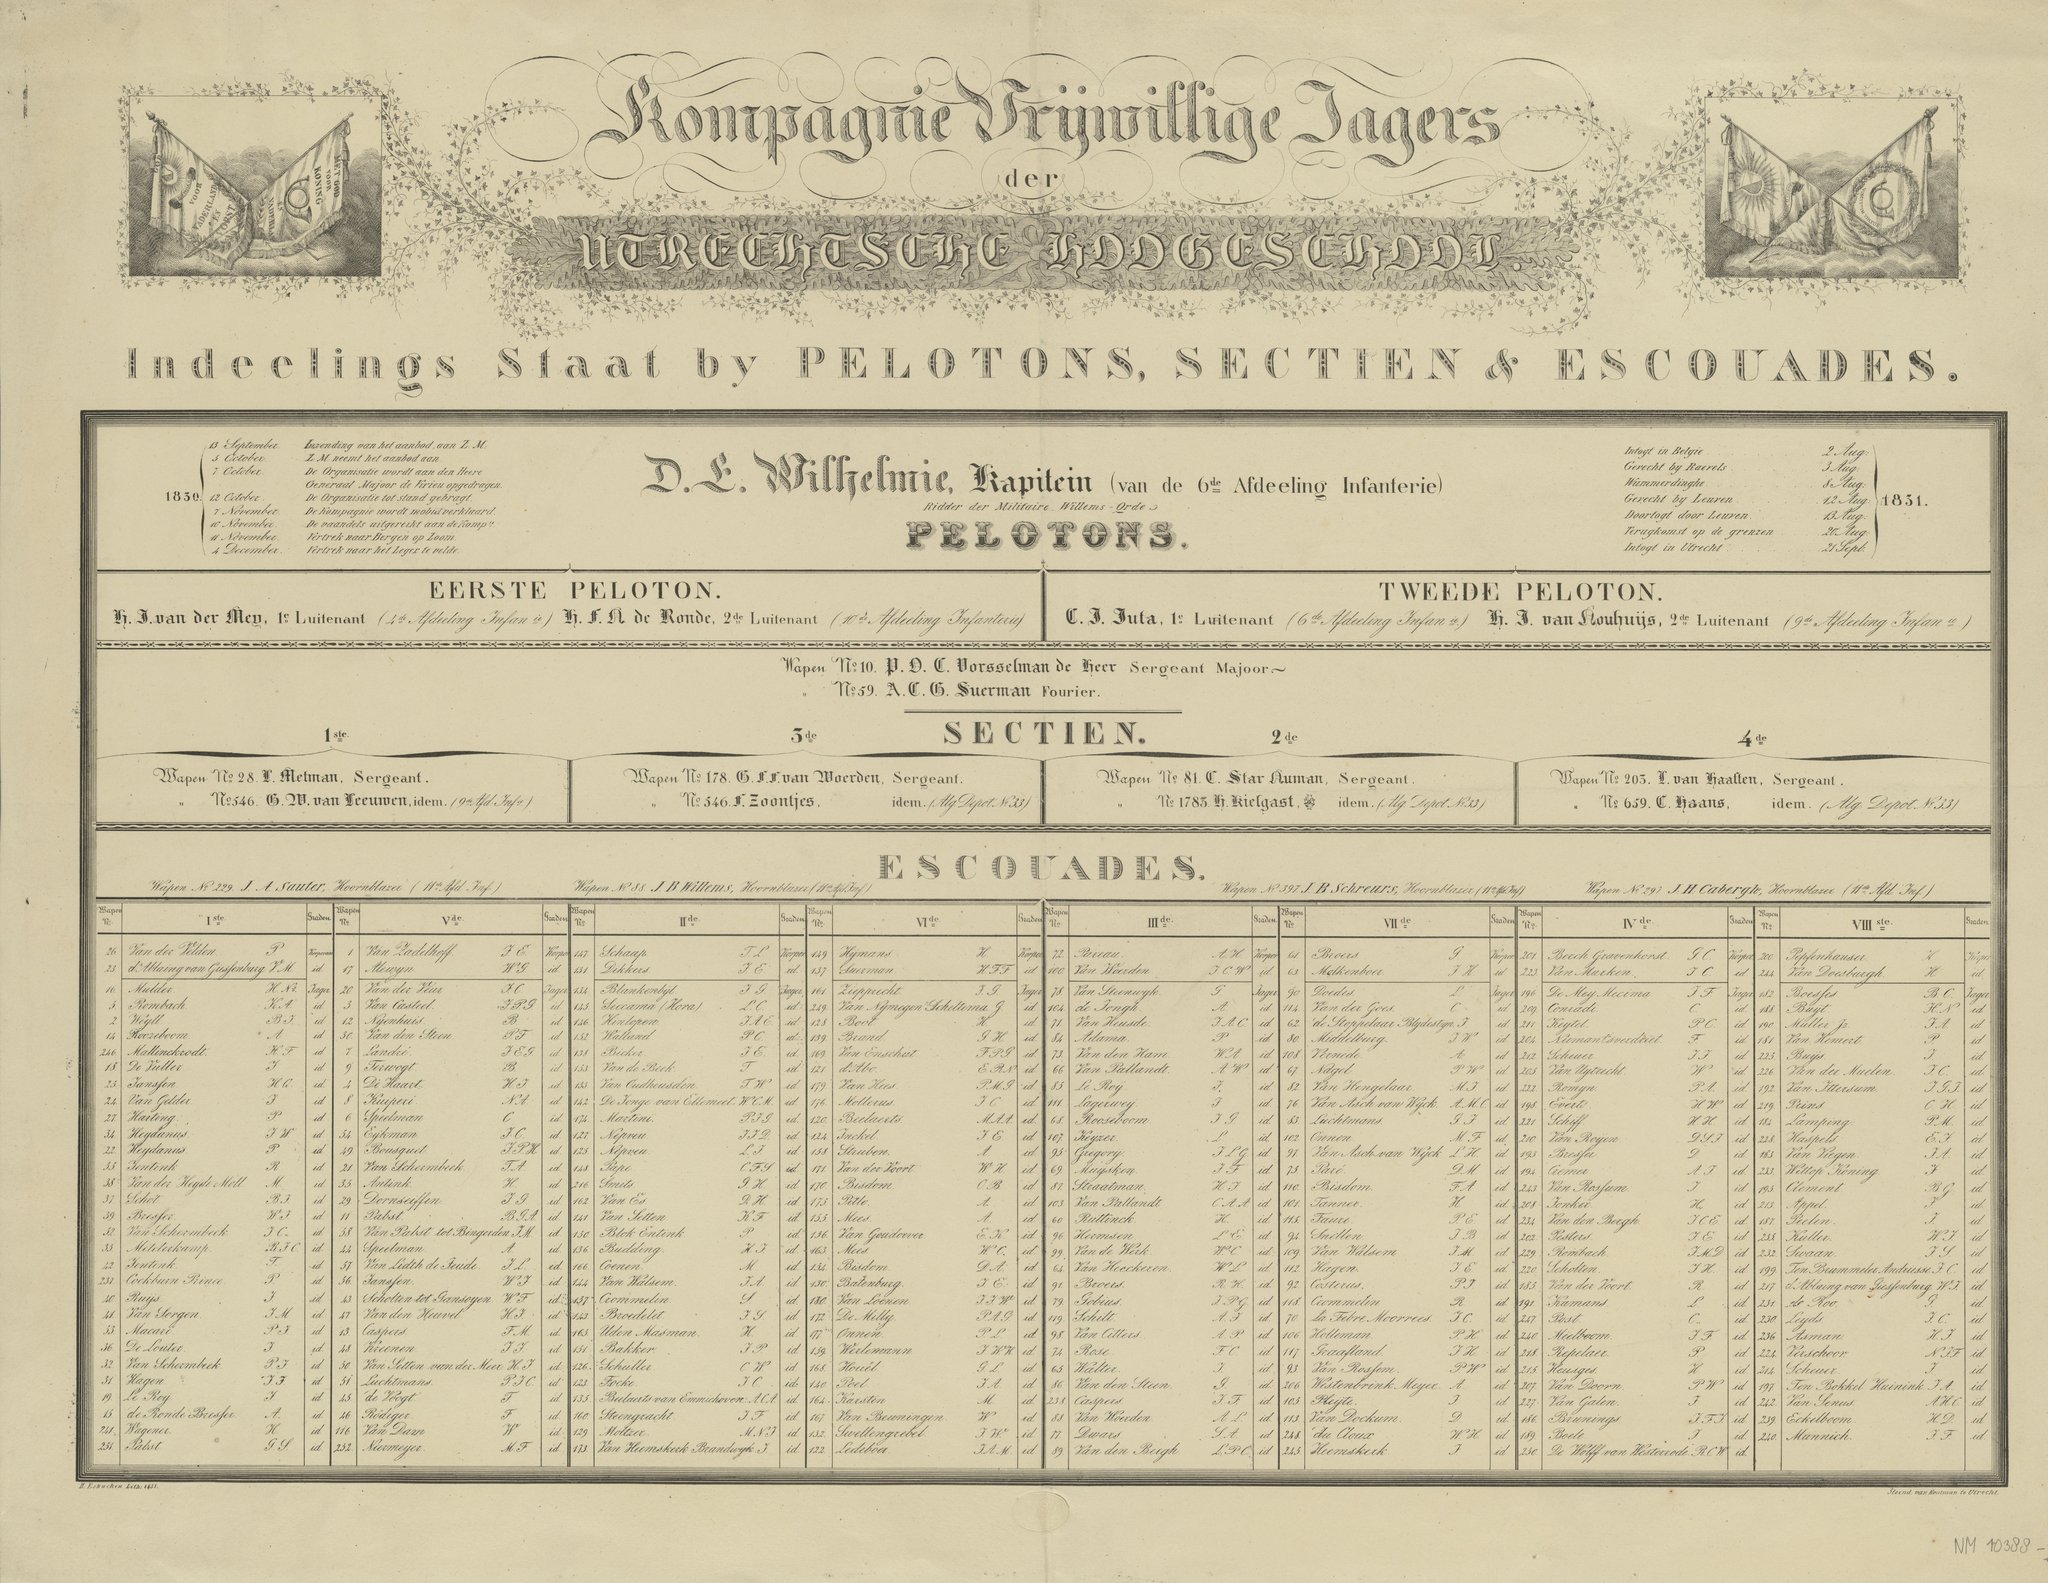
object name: sheet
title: Indeelings Staat bij pelotons, sectien & escoudes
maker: h. eskuchen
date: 1831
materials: paper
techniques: lithograph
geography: utrecht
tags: utrecht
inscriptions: date